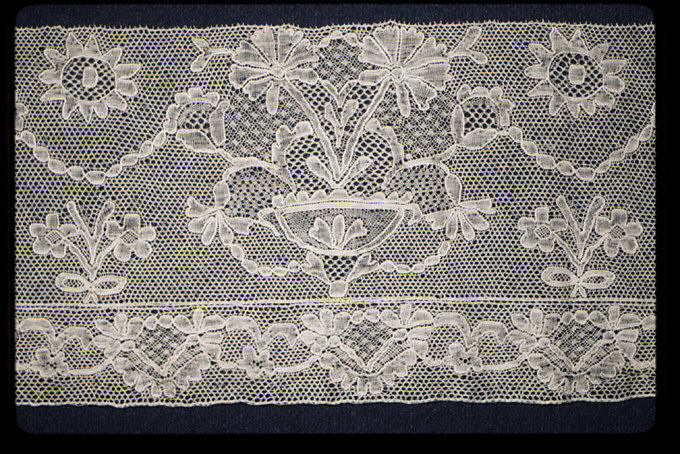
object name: border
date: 1750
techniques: lace